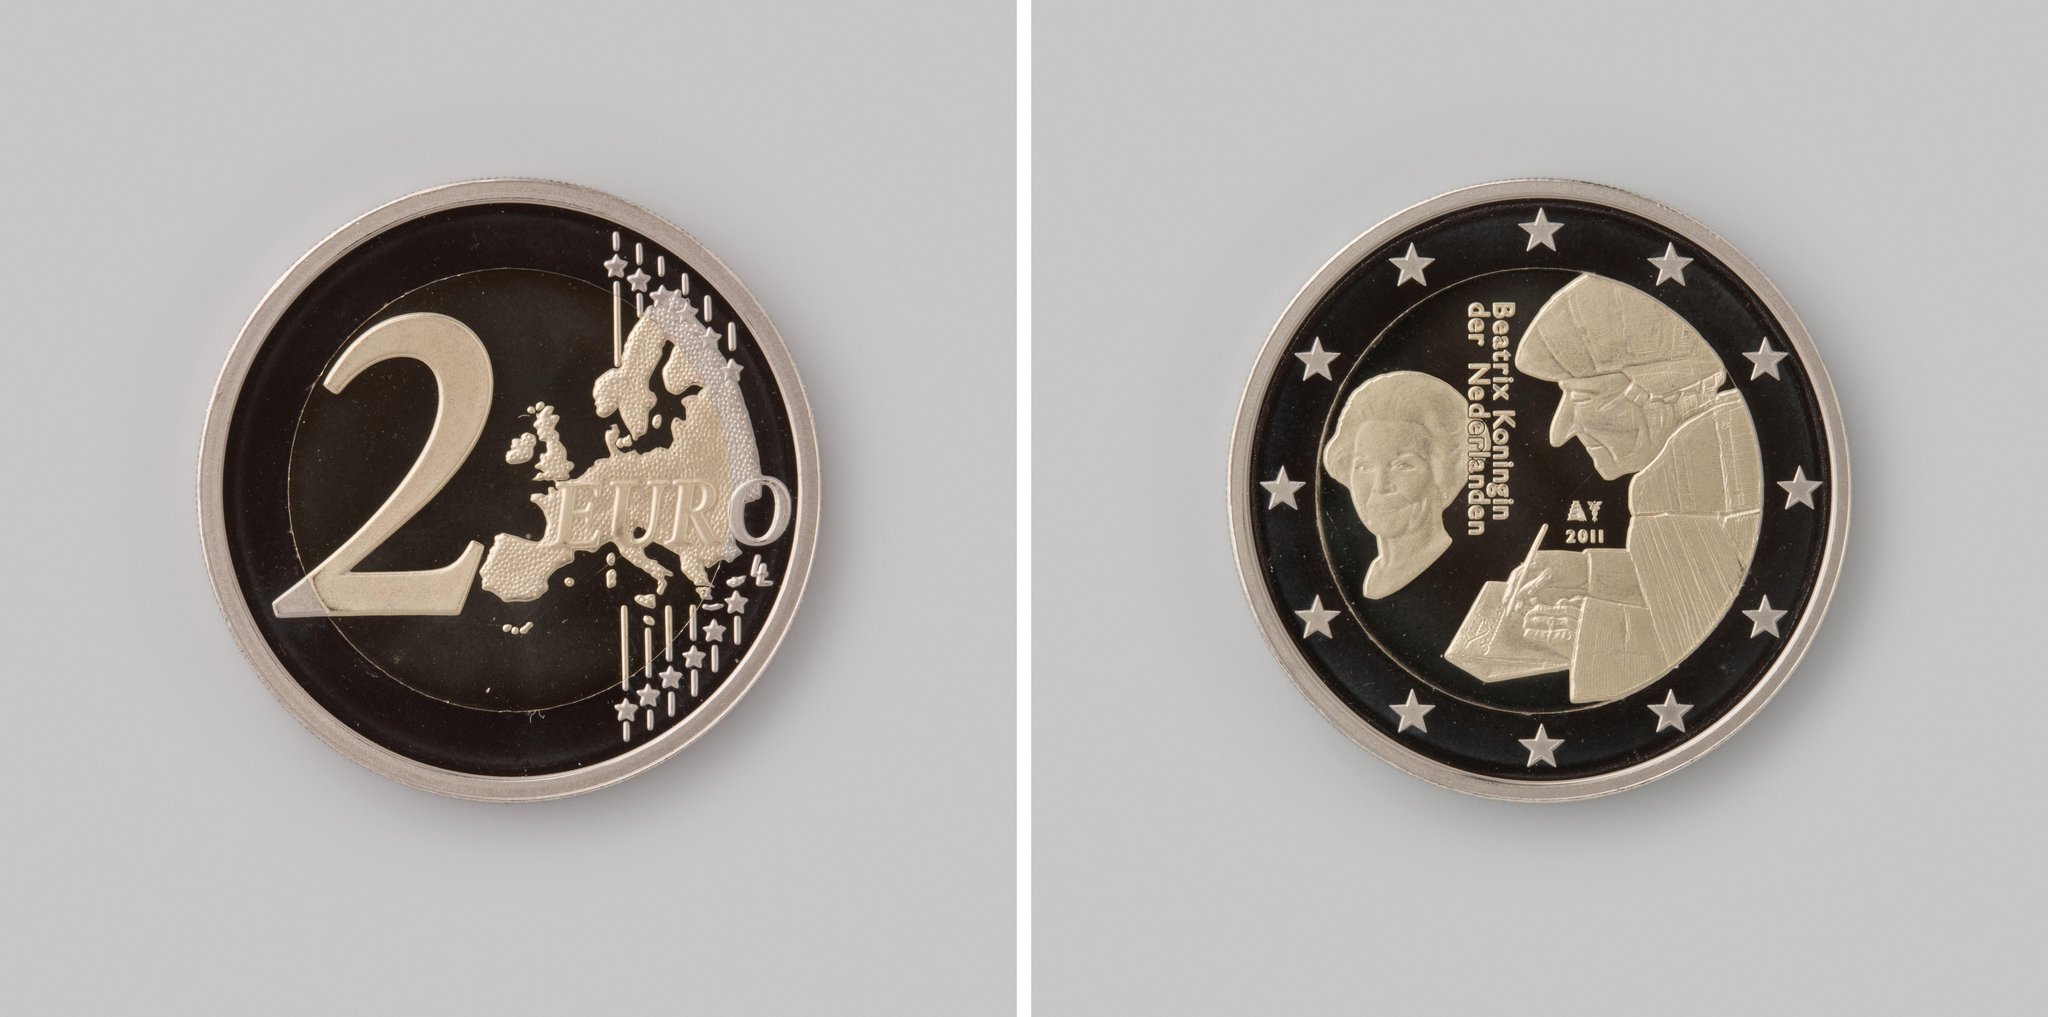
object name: commemorative coin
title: Eerste Slag: Erasmus Laus Stultitiae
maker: dylan shields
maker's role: vormgever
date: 2011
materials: silver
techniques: striking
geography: england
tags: rotterdam, desiderius erasmus, beatrix (koningin der nederlanden)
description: Zilveren munt (herdenkingsmunt) van 2 Euro. Voorzijde munt: band met 12 sterren, waarbinnen rechts portret van een schrijvende man in profiel (Erasmus) en links een kleiner portret van een ons aankijkende vrouw (koningin Beatrix); rechts van haar verticaal een tekst ("Beatrix Koningin der Nederlanden"). Keerzijde: opschrift "2 Euro" tegen achtergrond van kaart van Europa (gelijk aan gewone 2-euromunt). De rand is gekarteld met de tekst "GOD*ZIJ*MET*ONS".